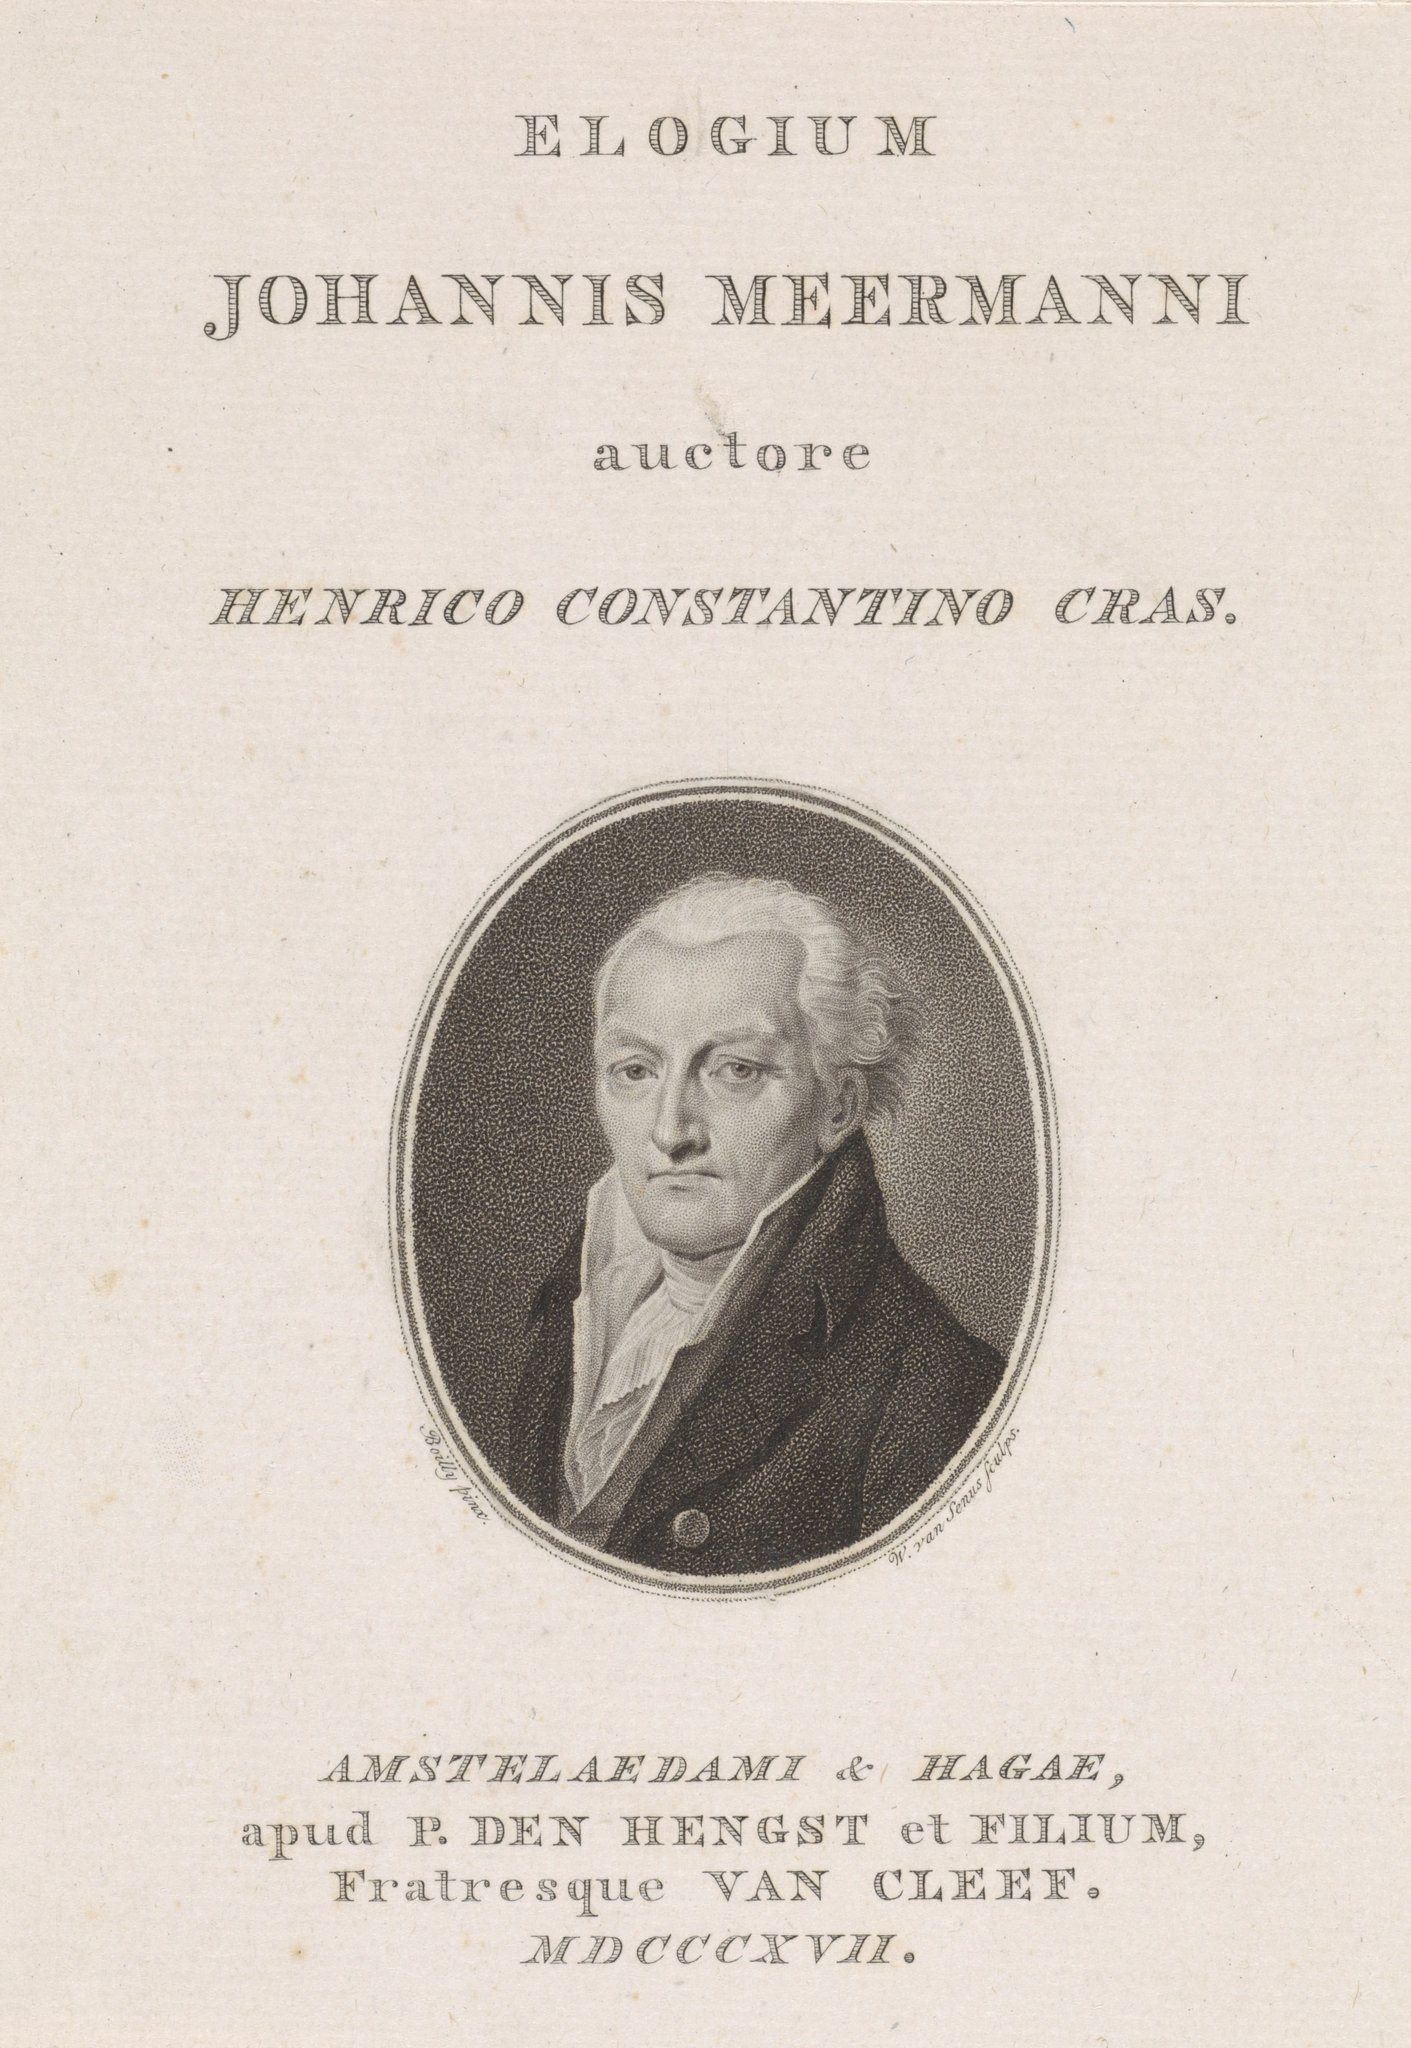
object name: print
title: Portret van Johan Meerman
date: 1817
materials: paper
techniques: engraving, etching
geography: amsterdam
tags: verzamelaar, johan meerman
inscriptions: collector's mark: Lugt 2228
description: Titelpagina voor: Cras, Henrik Constantyn. Elogium Johannis Meermanni. Amsterdam en Den Haag: Petrus den Hengst, 1817.